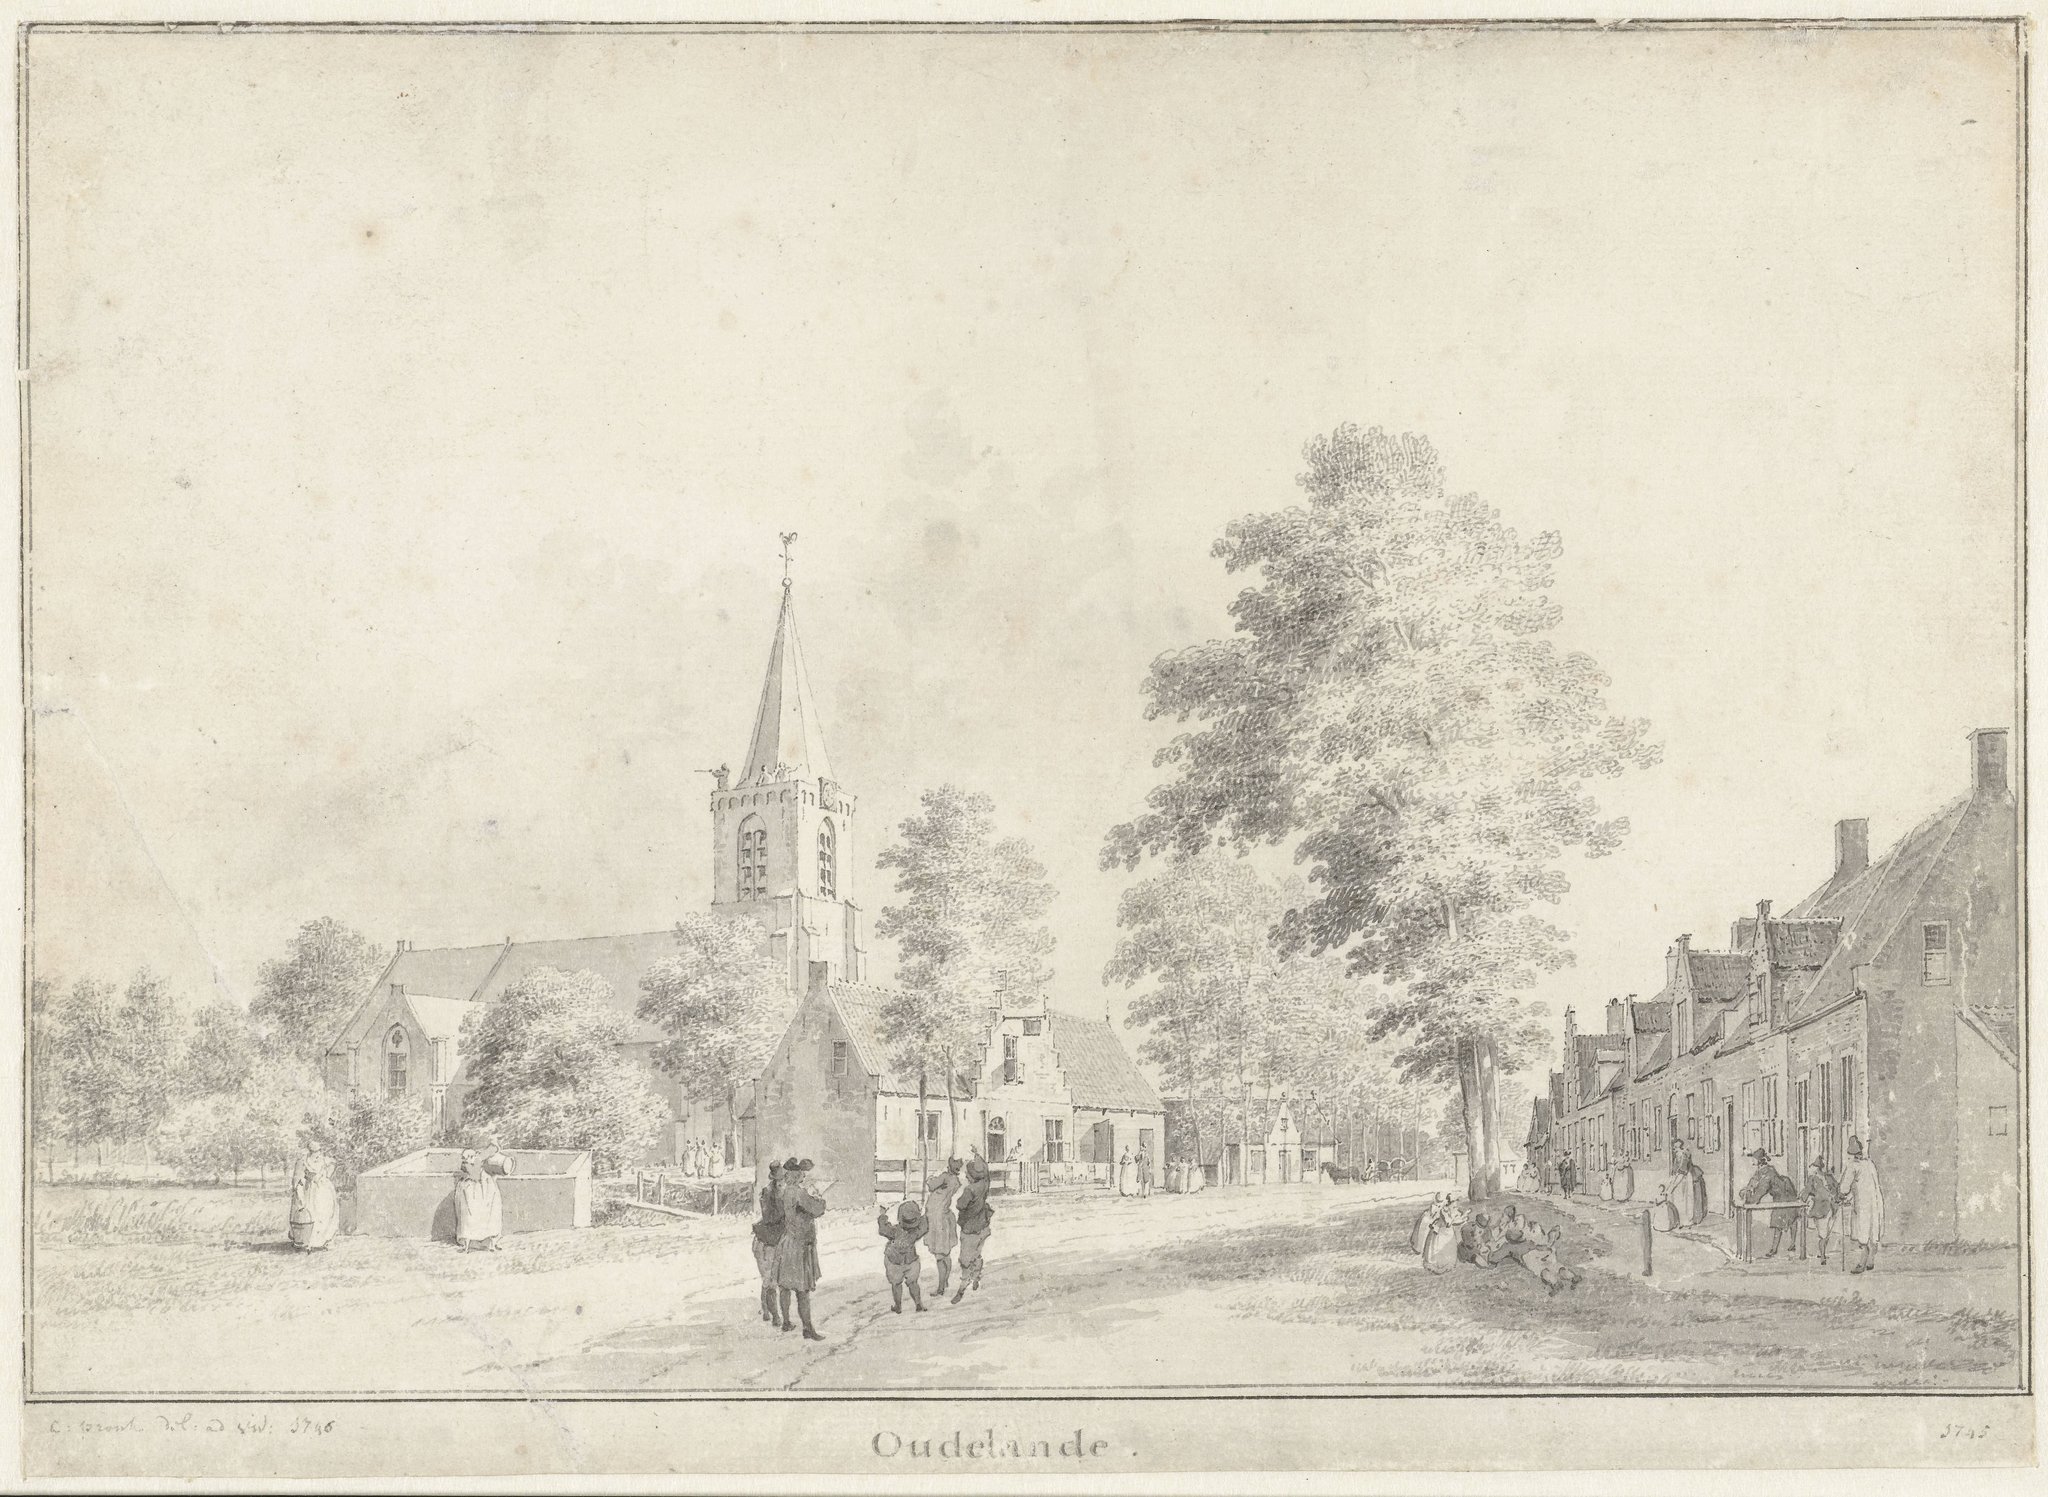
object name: drawing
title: Gezicht te Oudelande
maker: cornelis pronk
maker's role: draughtsman, painter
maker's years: 1691-1759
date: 1746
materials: ink, paper, pencil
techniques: brush, pen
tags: prospect of village, silhouette of village